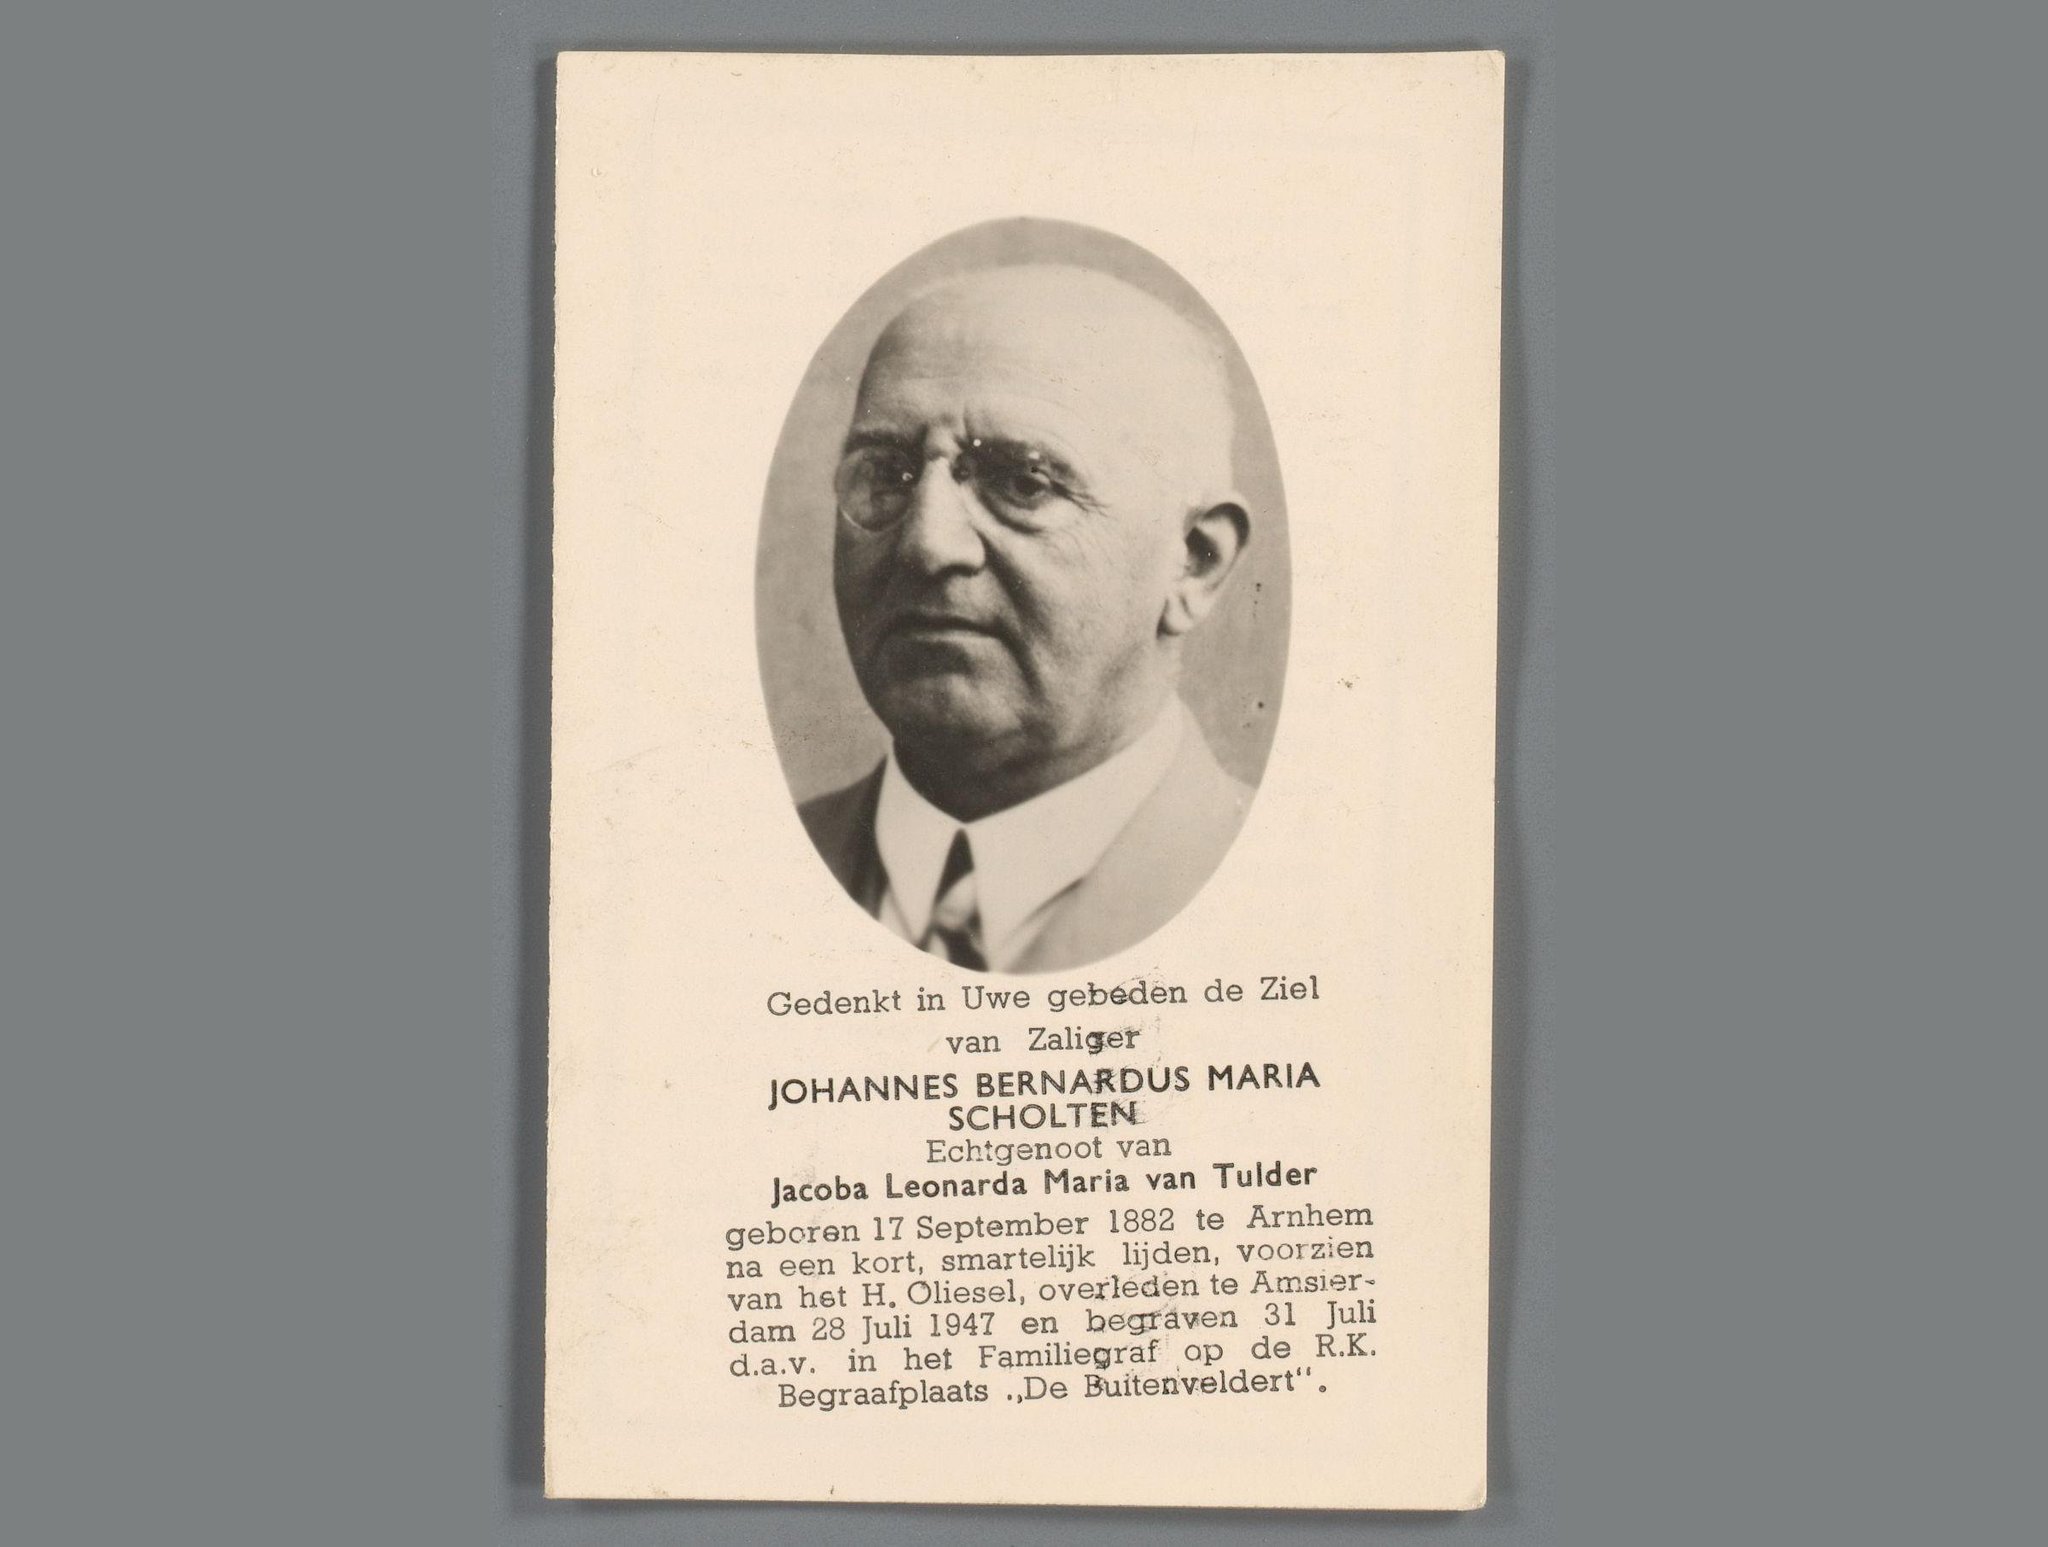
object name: prayer card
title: Portret van Johannes Bernardus Maria Scholten op bidprent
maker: Anonymous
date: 1947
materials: paper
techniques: gelatin silver print, letterpress printing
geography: amsterdam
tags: arnhem, historical persons, old man, amsterdam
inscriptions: inscription: ‘Onverwacht, maar niet onvoorbereid. (...) Hij ruste in vrede.’, inscription: ‘Gedenkt in Uwe gebeden de Ziel (...) Begraafplaats "De Buitenveldert".’